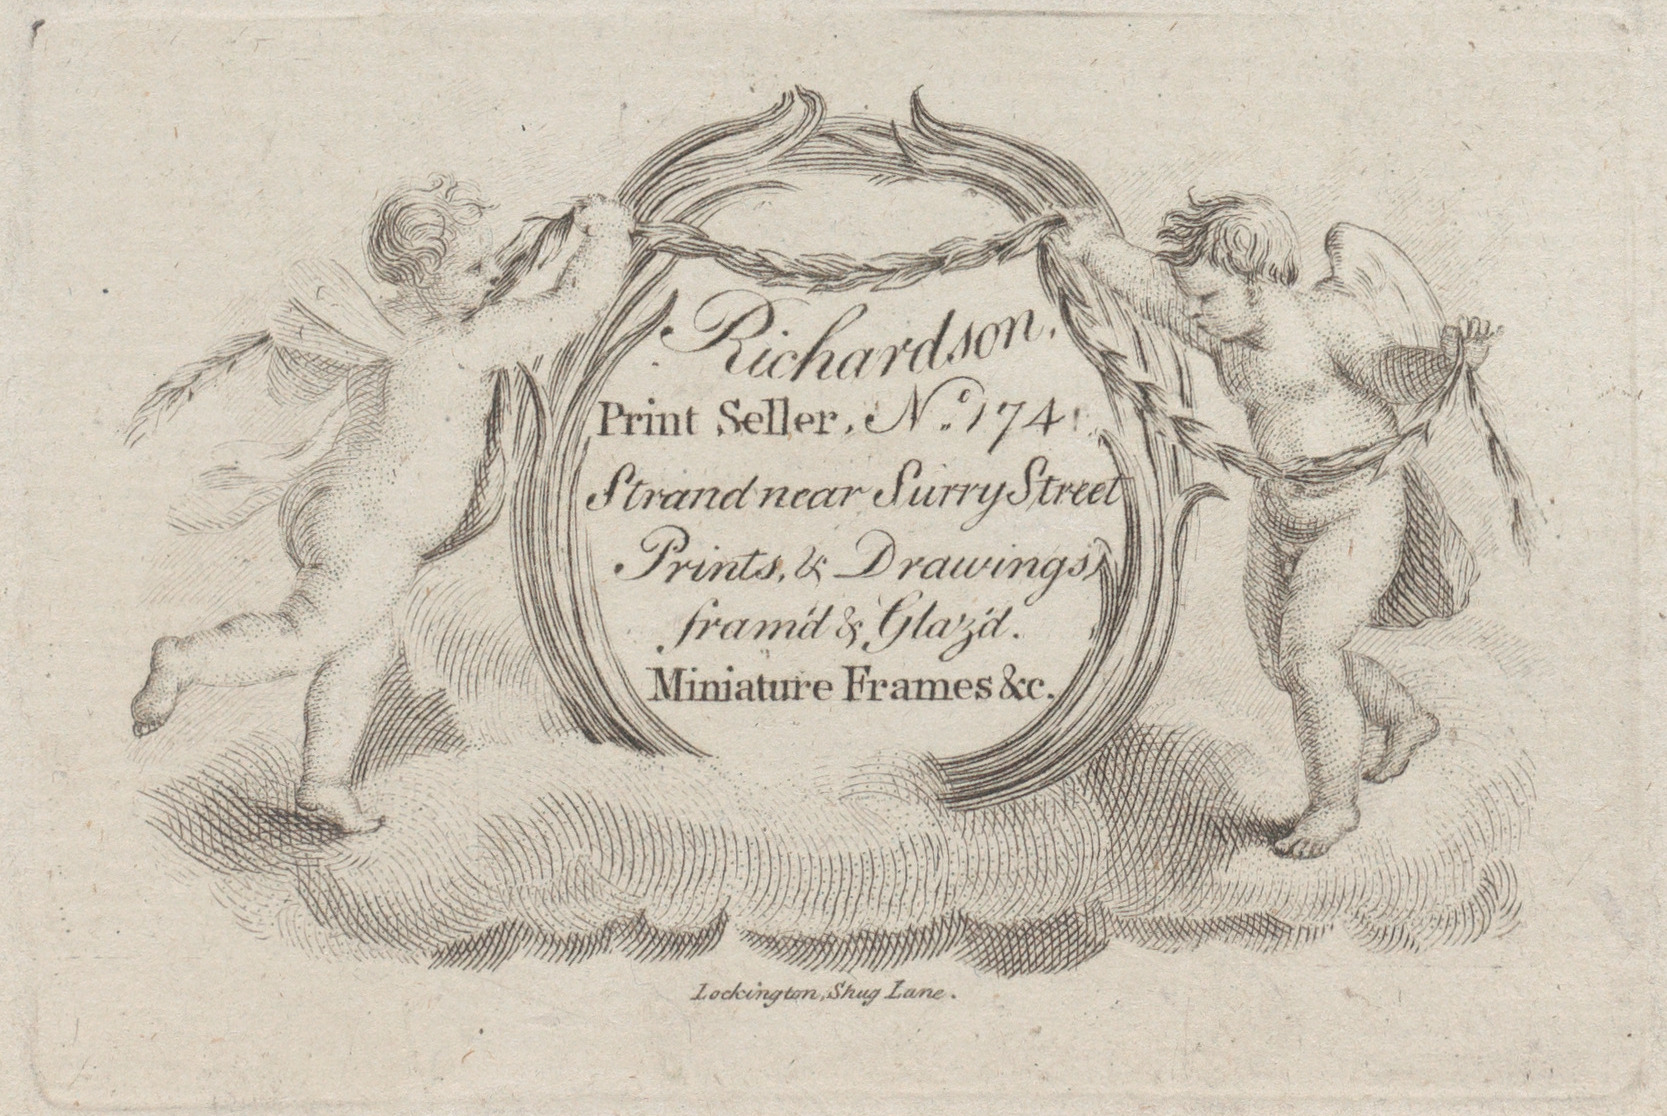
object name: print, trade card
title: Trade Card for William Richardson, Print Seller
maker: anonymous, british, 18th century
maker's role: artist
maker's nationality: british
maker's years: 1700-1800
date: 1701-1800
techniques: engraving